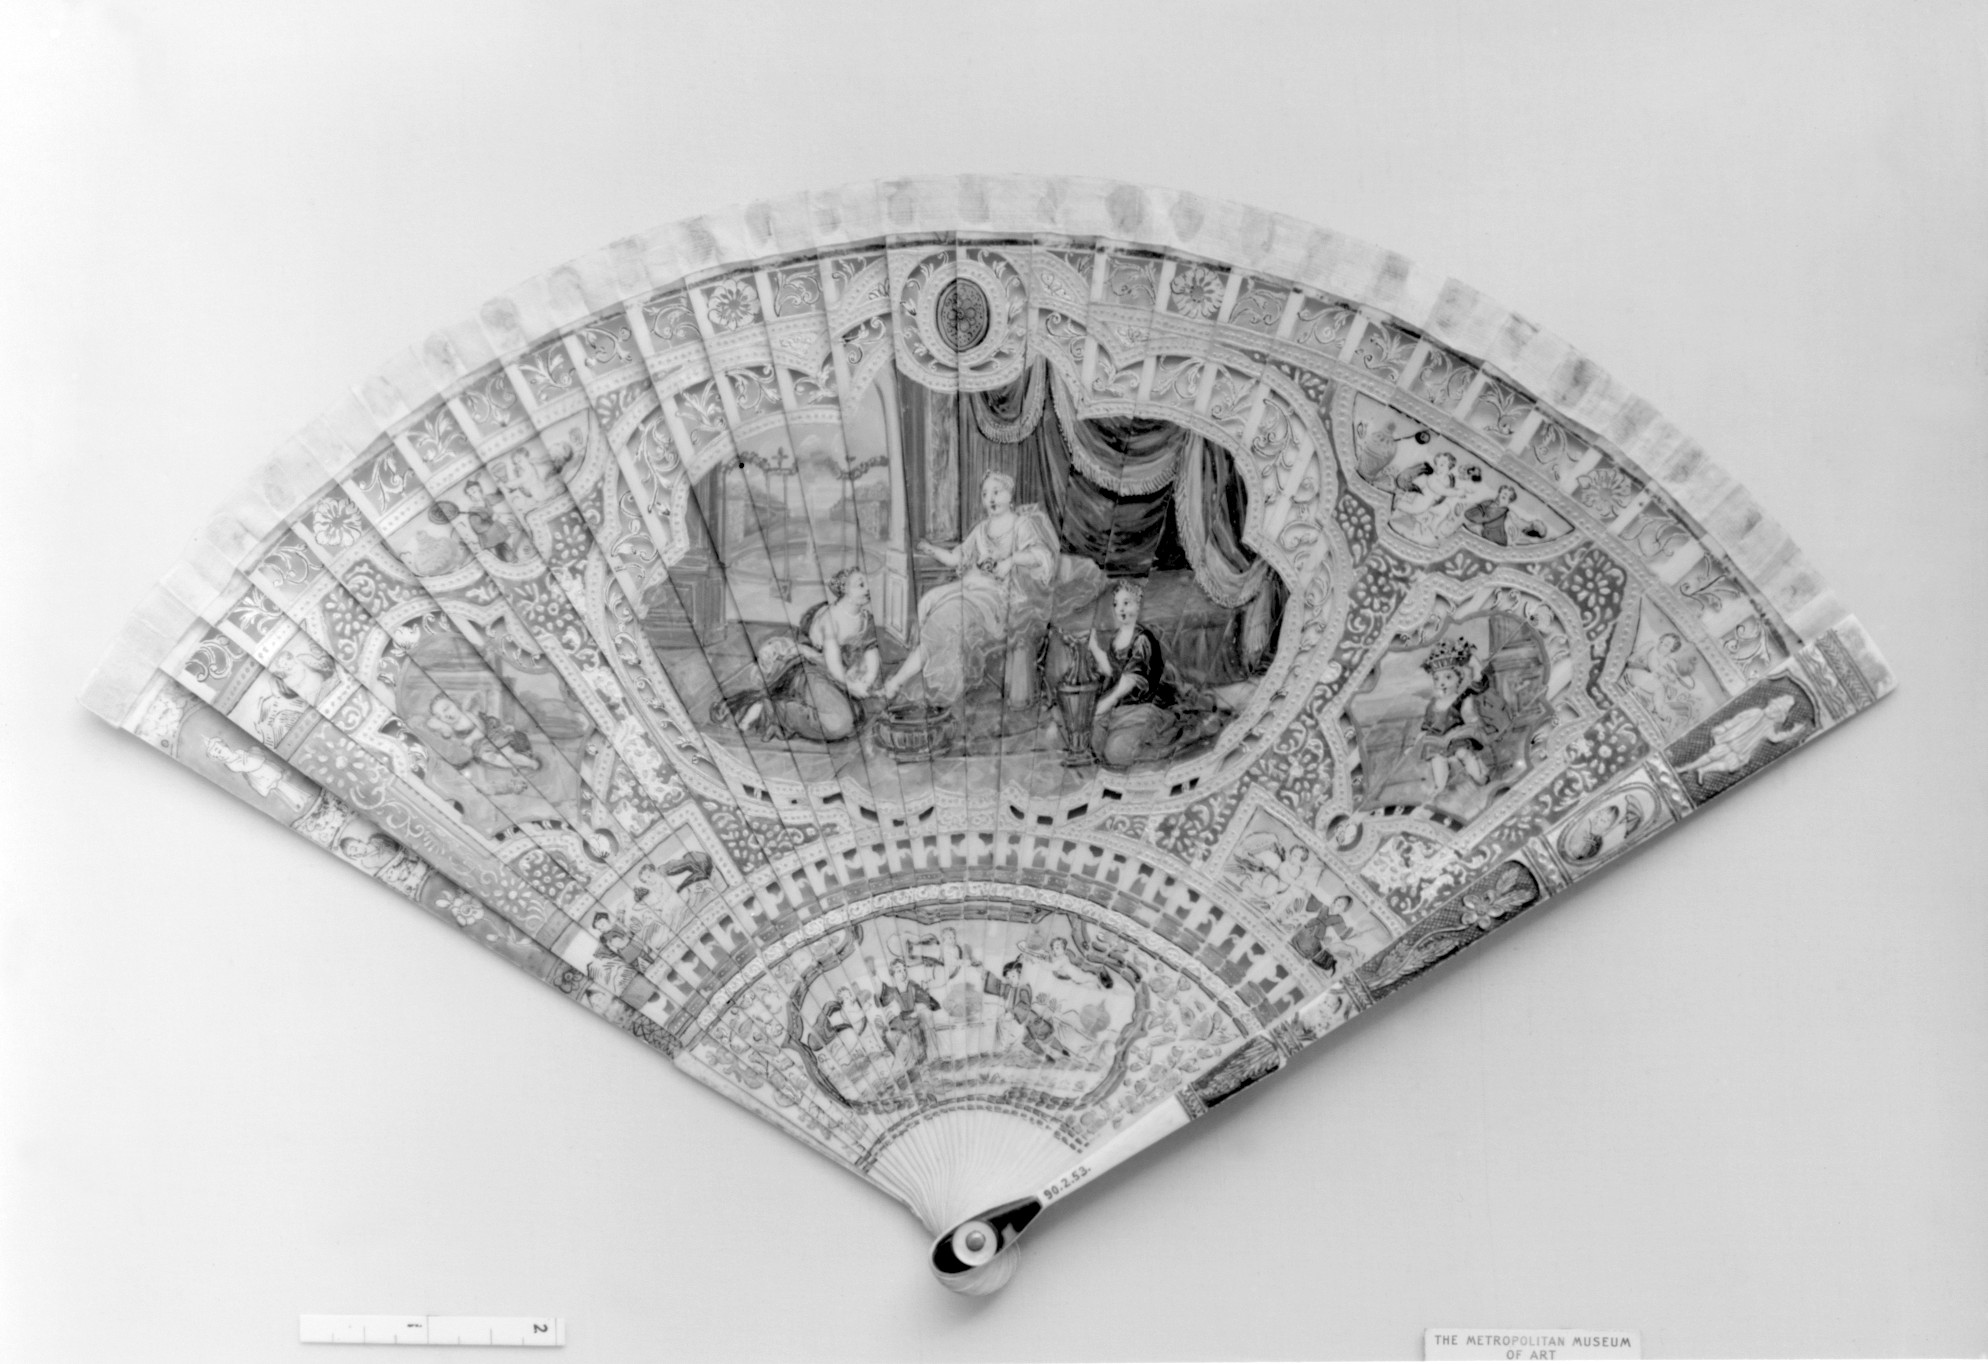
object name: fan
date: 1701-1733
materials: ivory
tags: women,beds